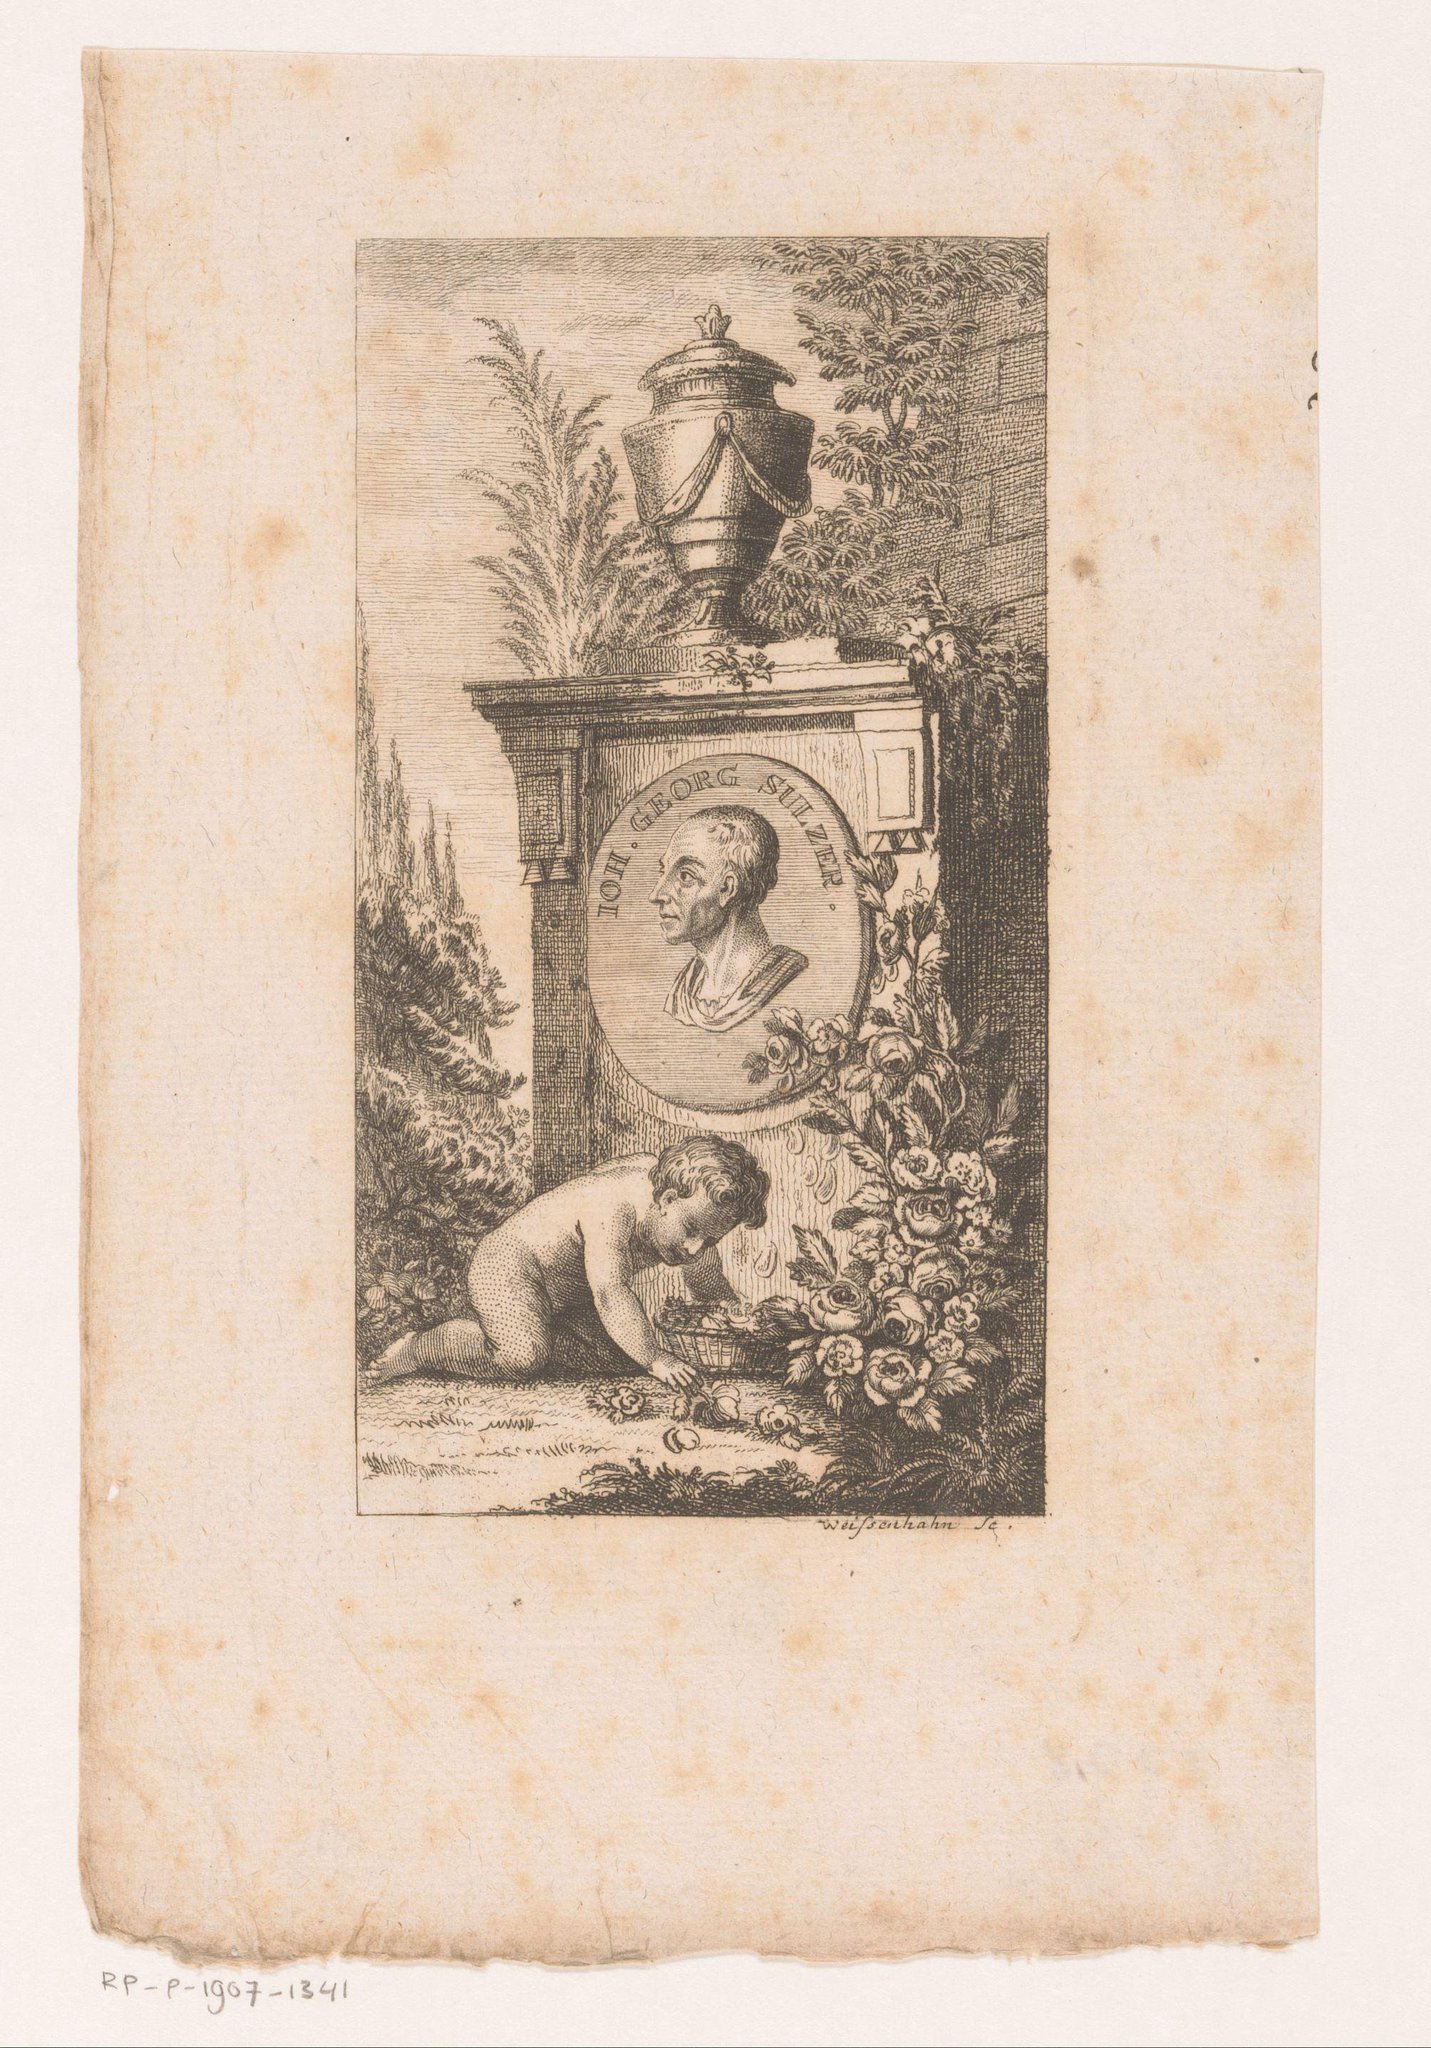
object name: print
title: Monument met het portret van Johann Georg Sulzer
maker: georg michael weissenhahn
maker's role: print maker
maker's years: 1741-1795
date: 1779-1795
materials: paper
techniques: etching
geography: germany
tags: berlin, historical persons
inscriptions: collector's mark: Lugt 2228